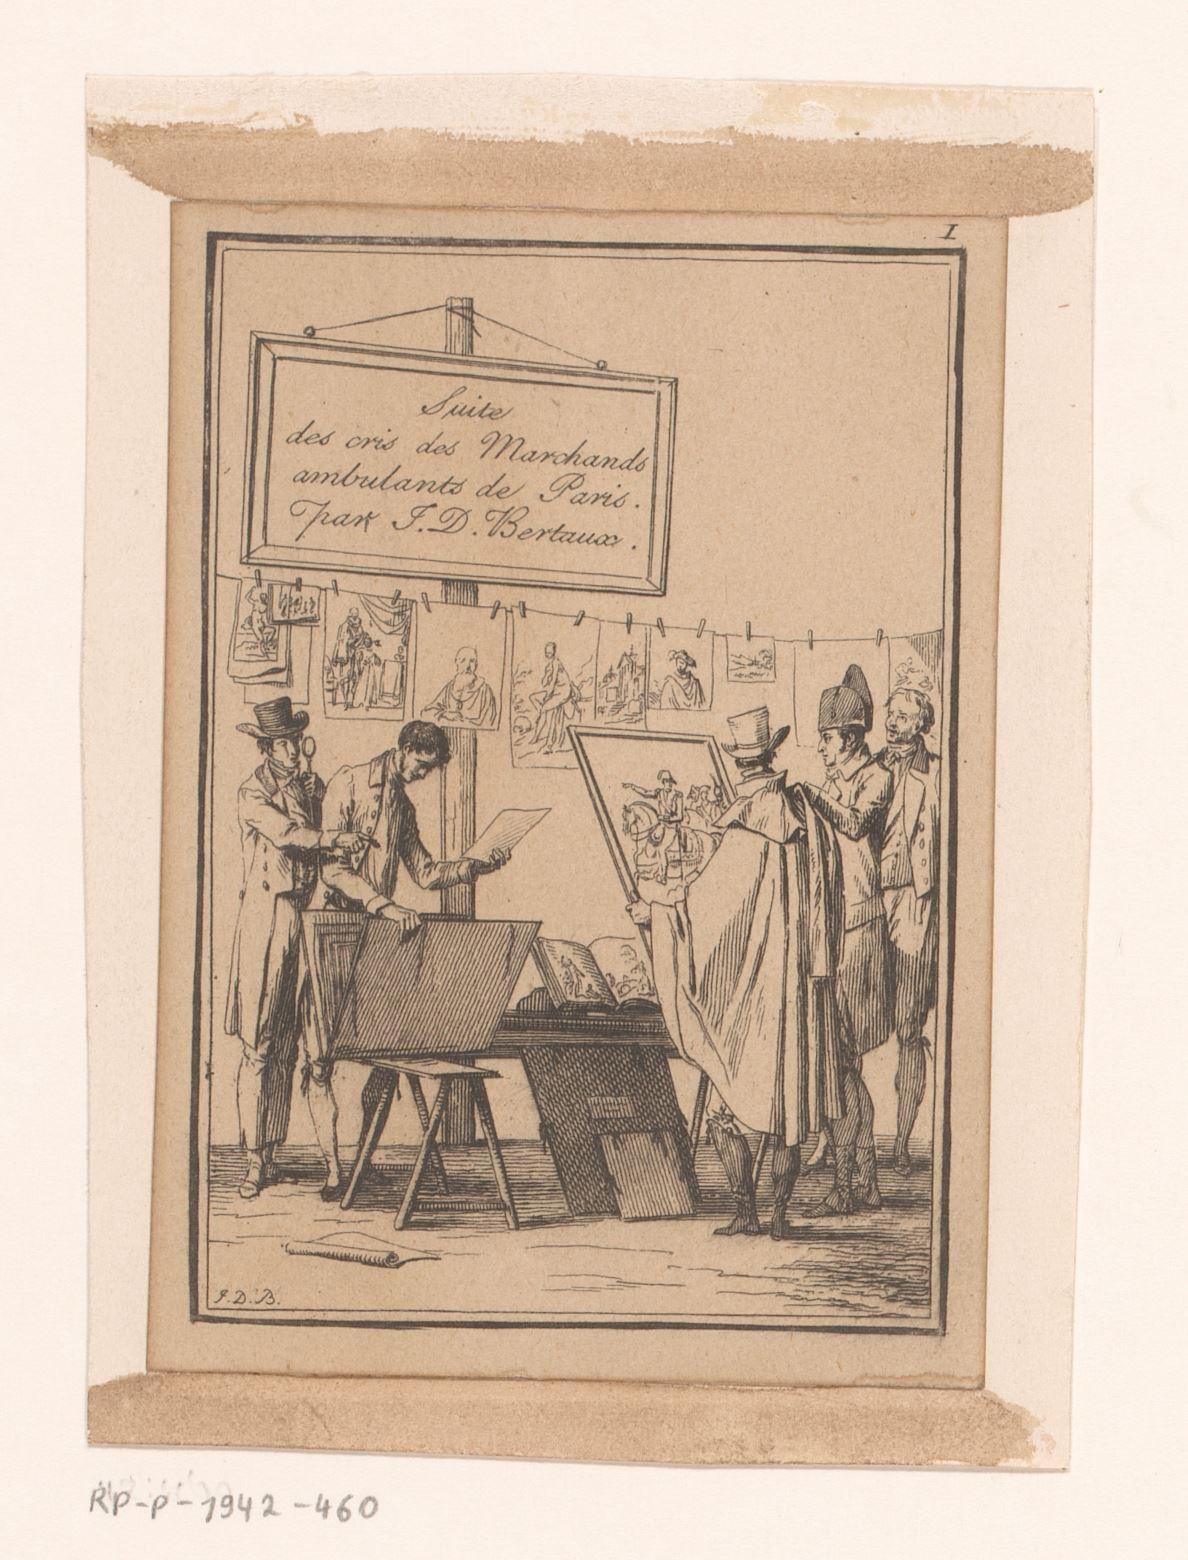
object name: titelprent, frontispice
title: Titelprent met kopers en verkopers van prenten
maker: jean duplessis-bertaux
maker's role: print maker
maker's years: 1750-1818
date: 1760-1818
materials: paper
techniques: etching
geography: france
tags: print, e.g.: engraving, etching, lithograph, auction sale, public sale, 'cris de paris', cries of london, etc.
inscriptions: collector's mark: Lugt 2228